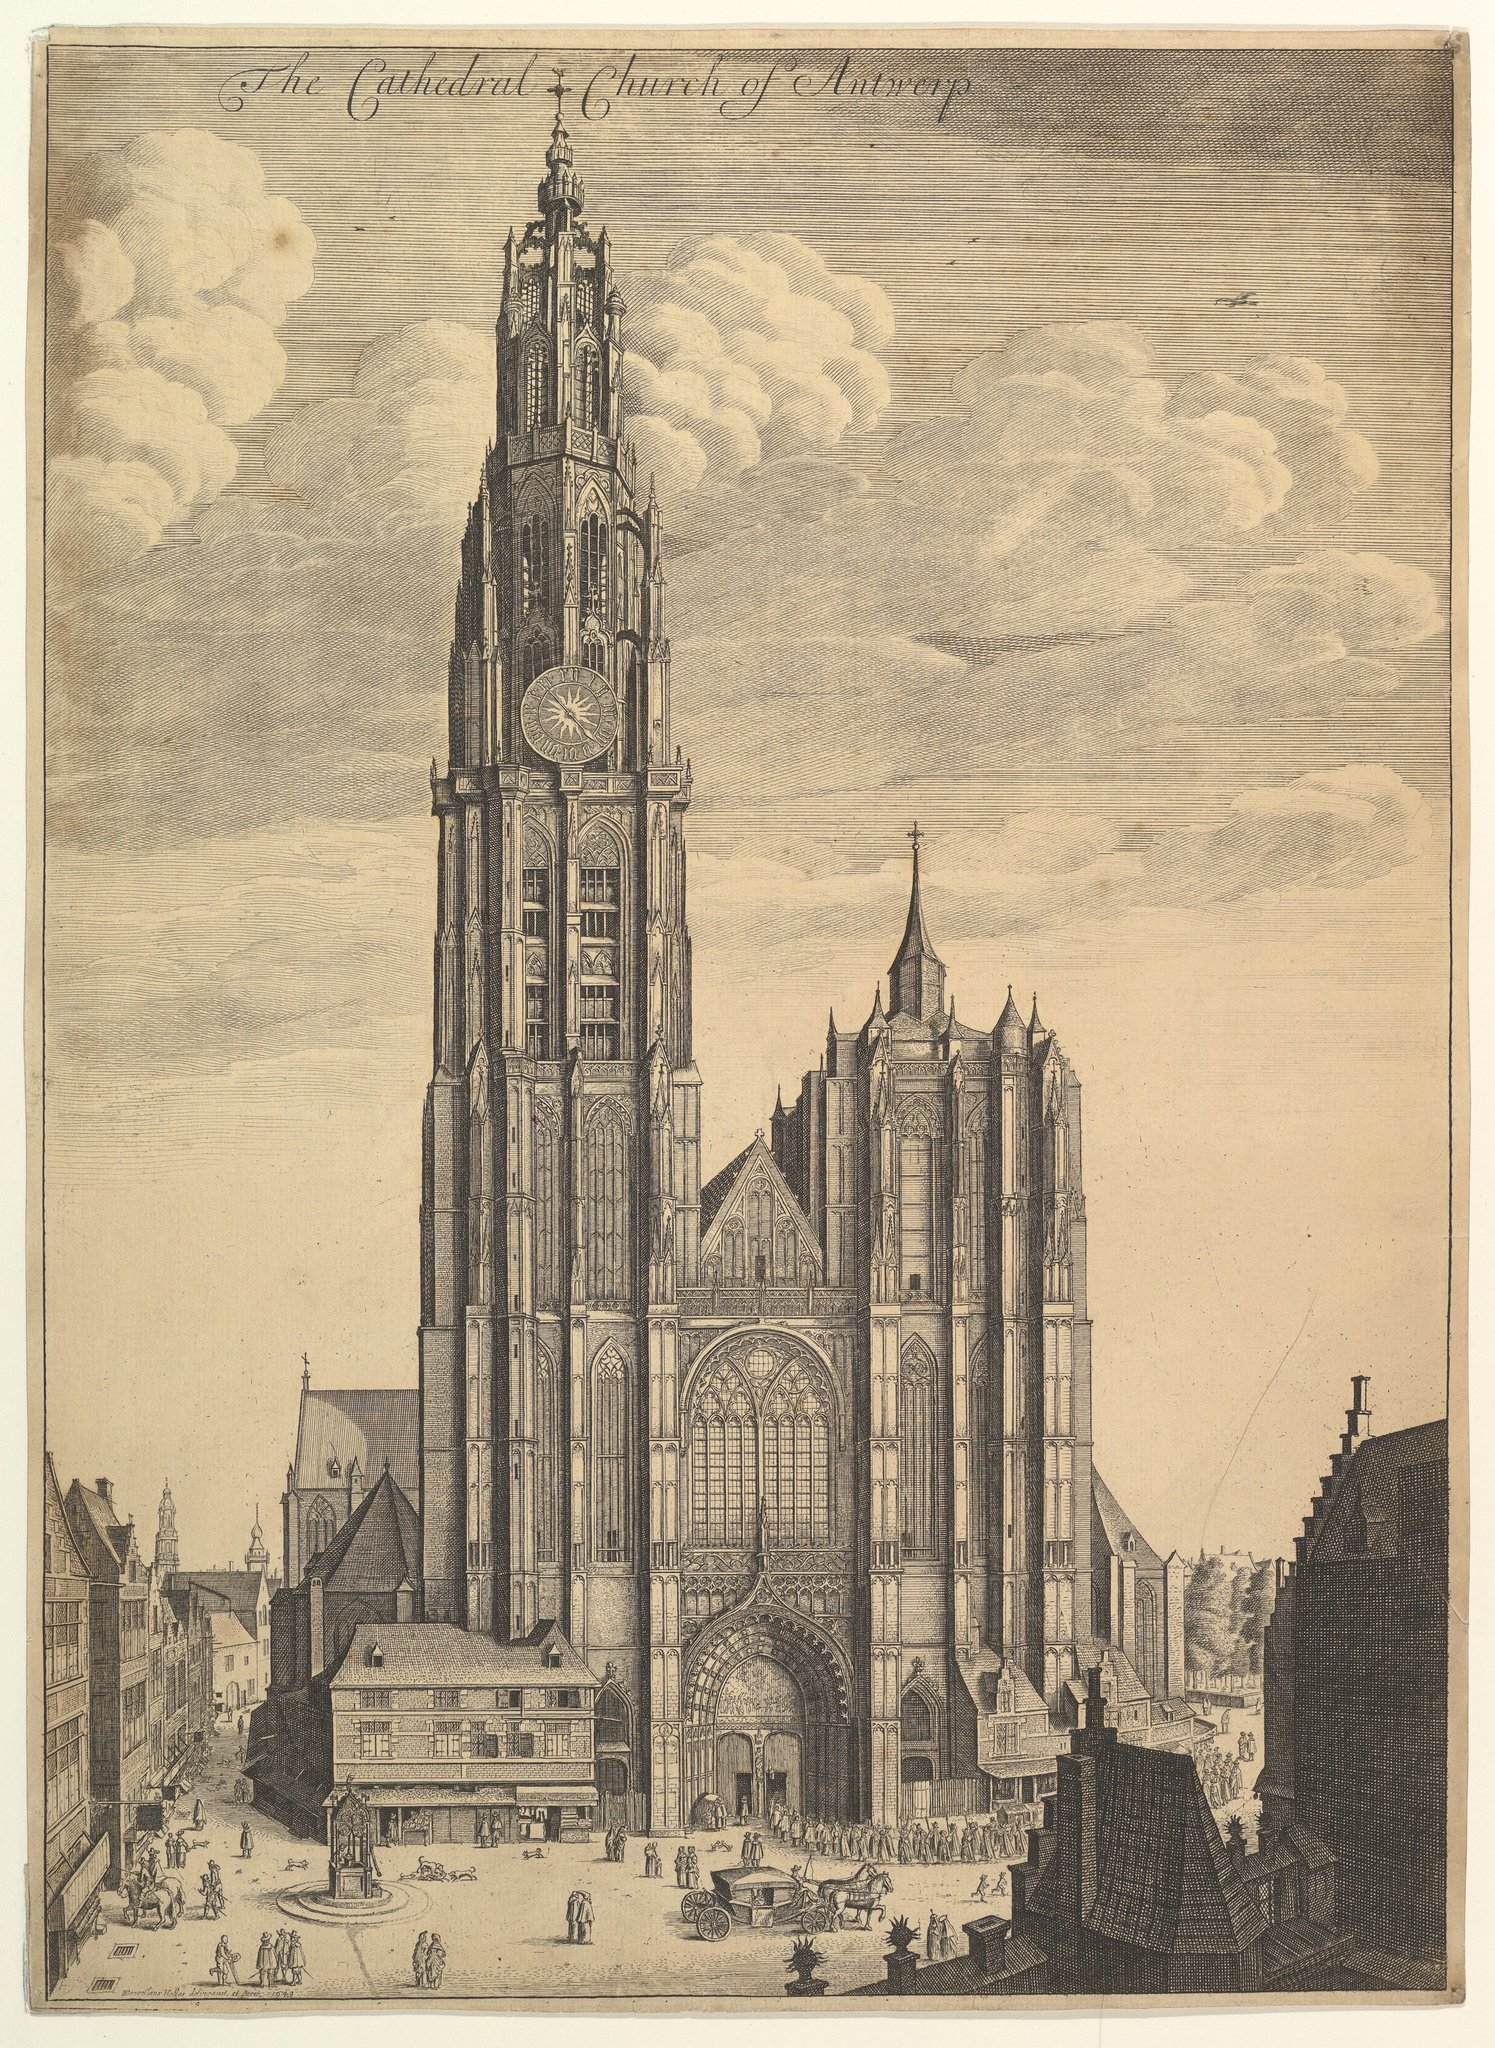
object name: print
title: Antwerp Cathedral (Prospectvs Tvrris Ecclesiæ Cathedralis)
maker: wenceslaus hollar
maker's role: artist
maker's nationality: bohemian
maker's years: 1607-1677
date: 1649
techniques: etching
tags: human figures,churches